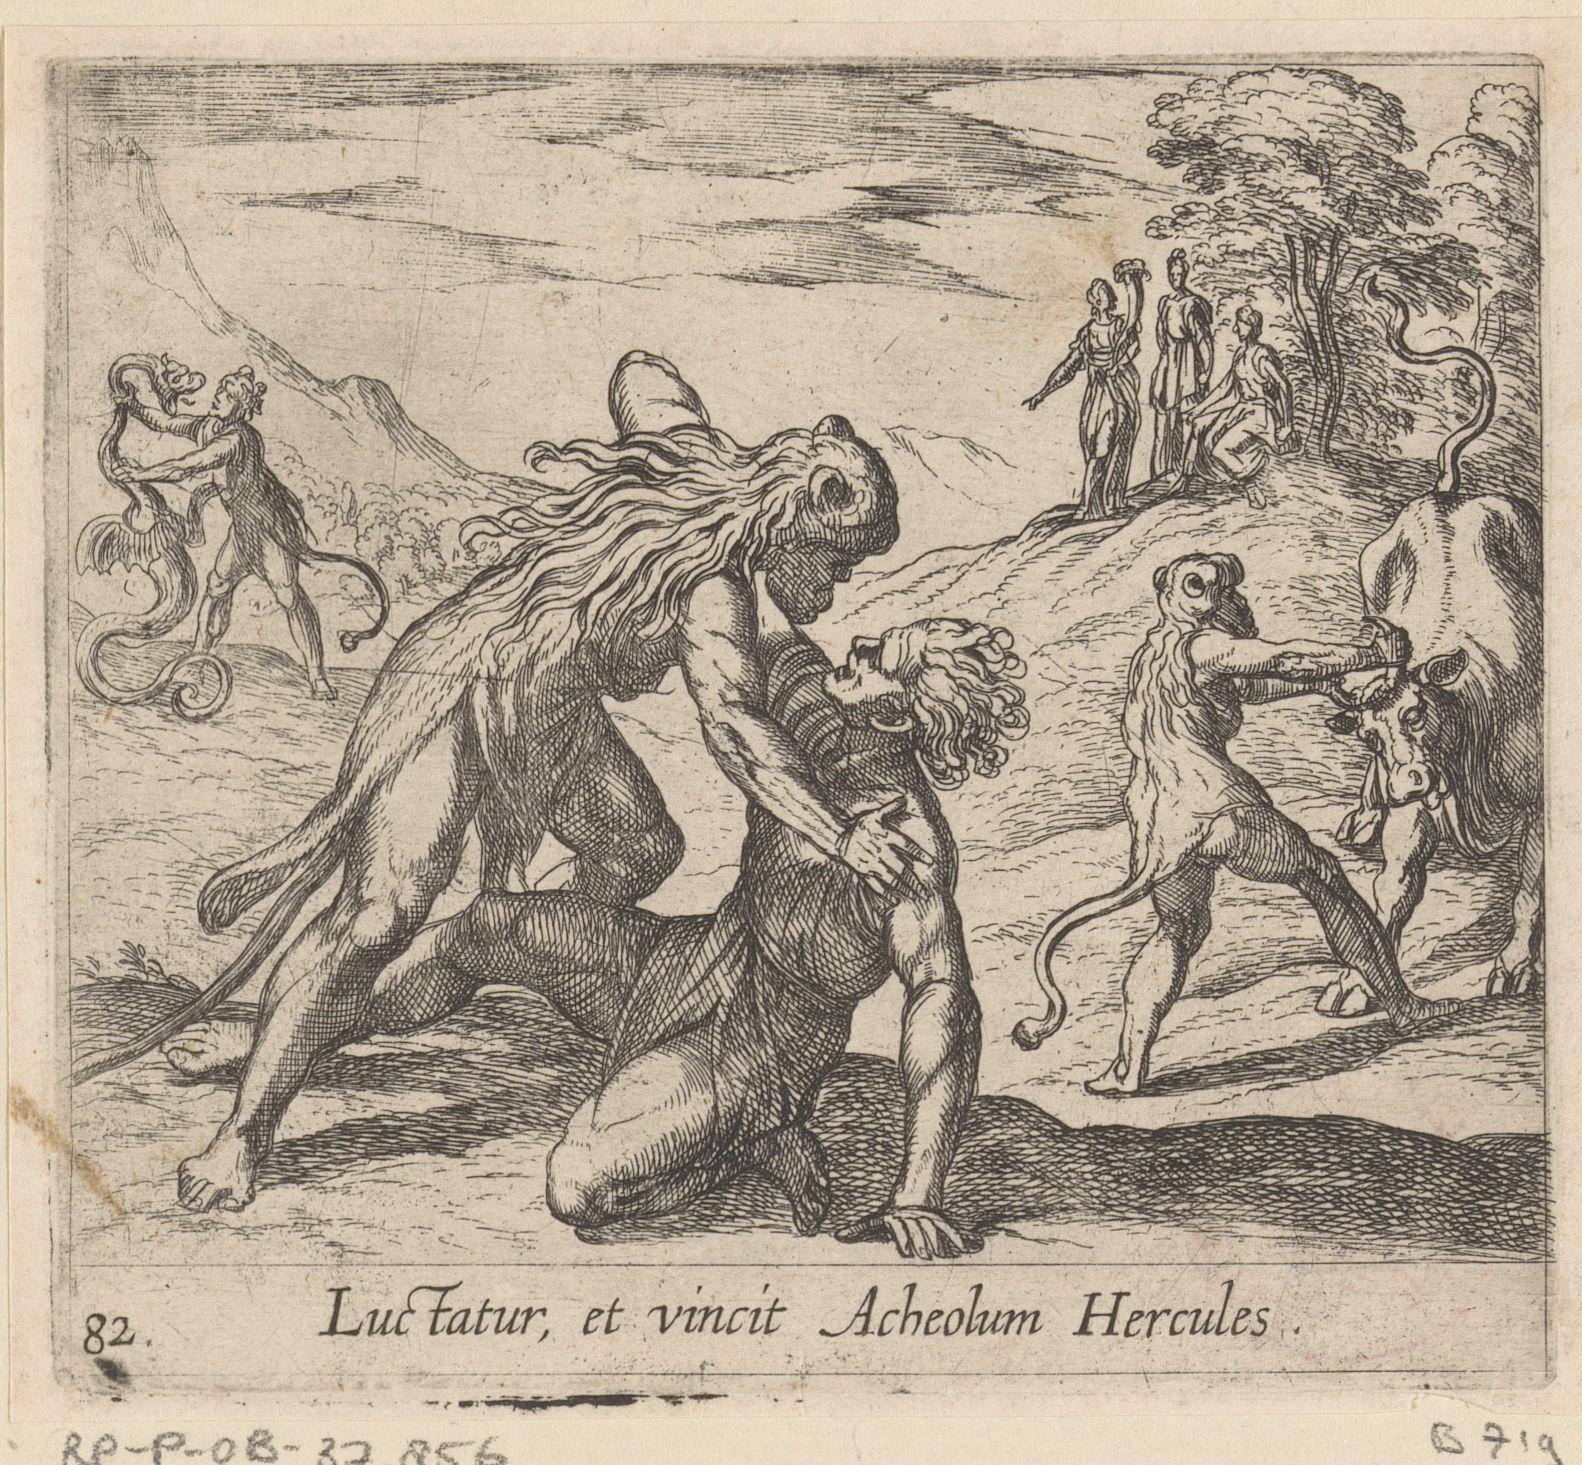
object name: print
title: Metamorphoseon sive transformationum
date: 1606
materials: paper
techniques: etching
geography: italy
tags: while fighting with hercules the river-god achelous changes himself into a serpent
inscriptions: collector's mark: Lugt 240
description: Hercules in gevecht met de riviergod Acheloüs om Deïanira, de dochter van de riviergod Oeneus. Links heeft Acheloüs de gedaante aangenomen van een serpent. Rechts heeft hij de gedaante aangenomen van een stier. Op de voorgrond is hij in menselijke gedaante aan het worstelen met Hercules. Titel in het Latijn in ondermarge.